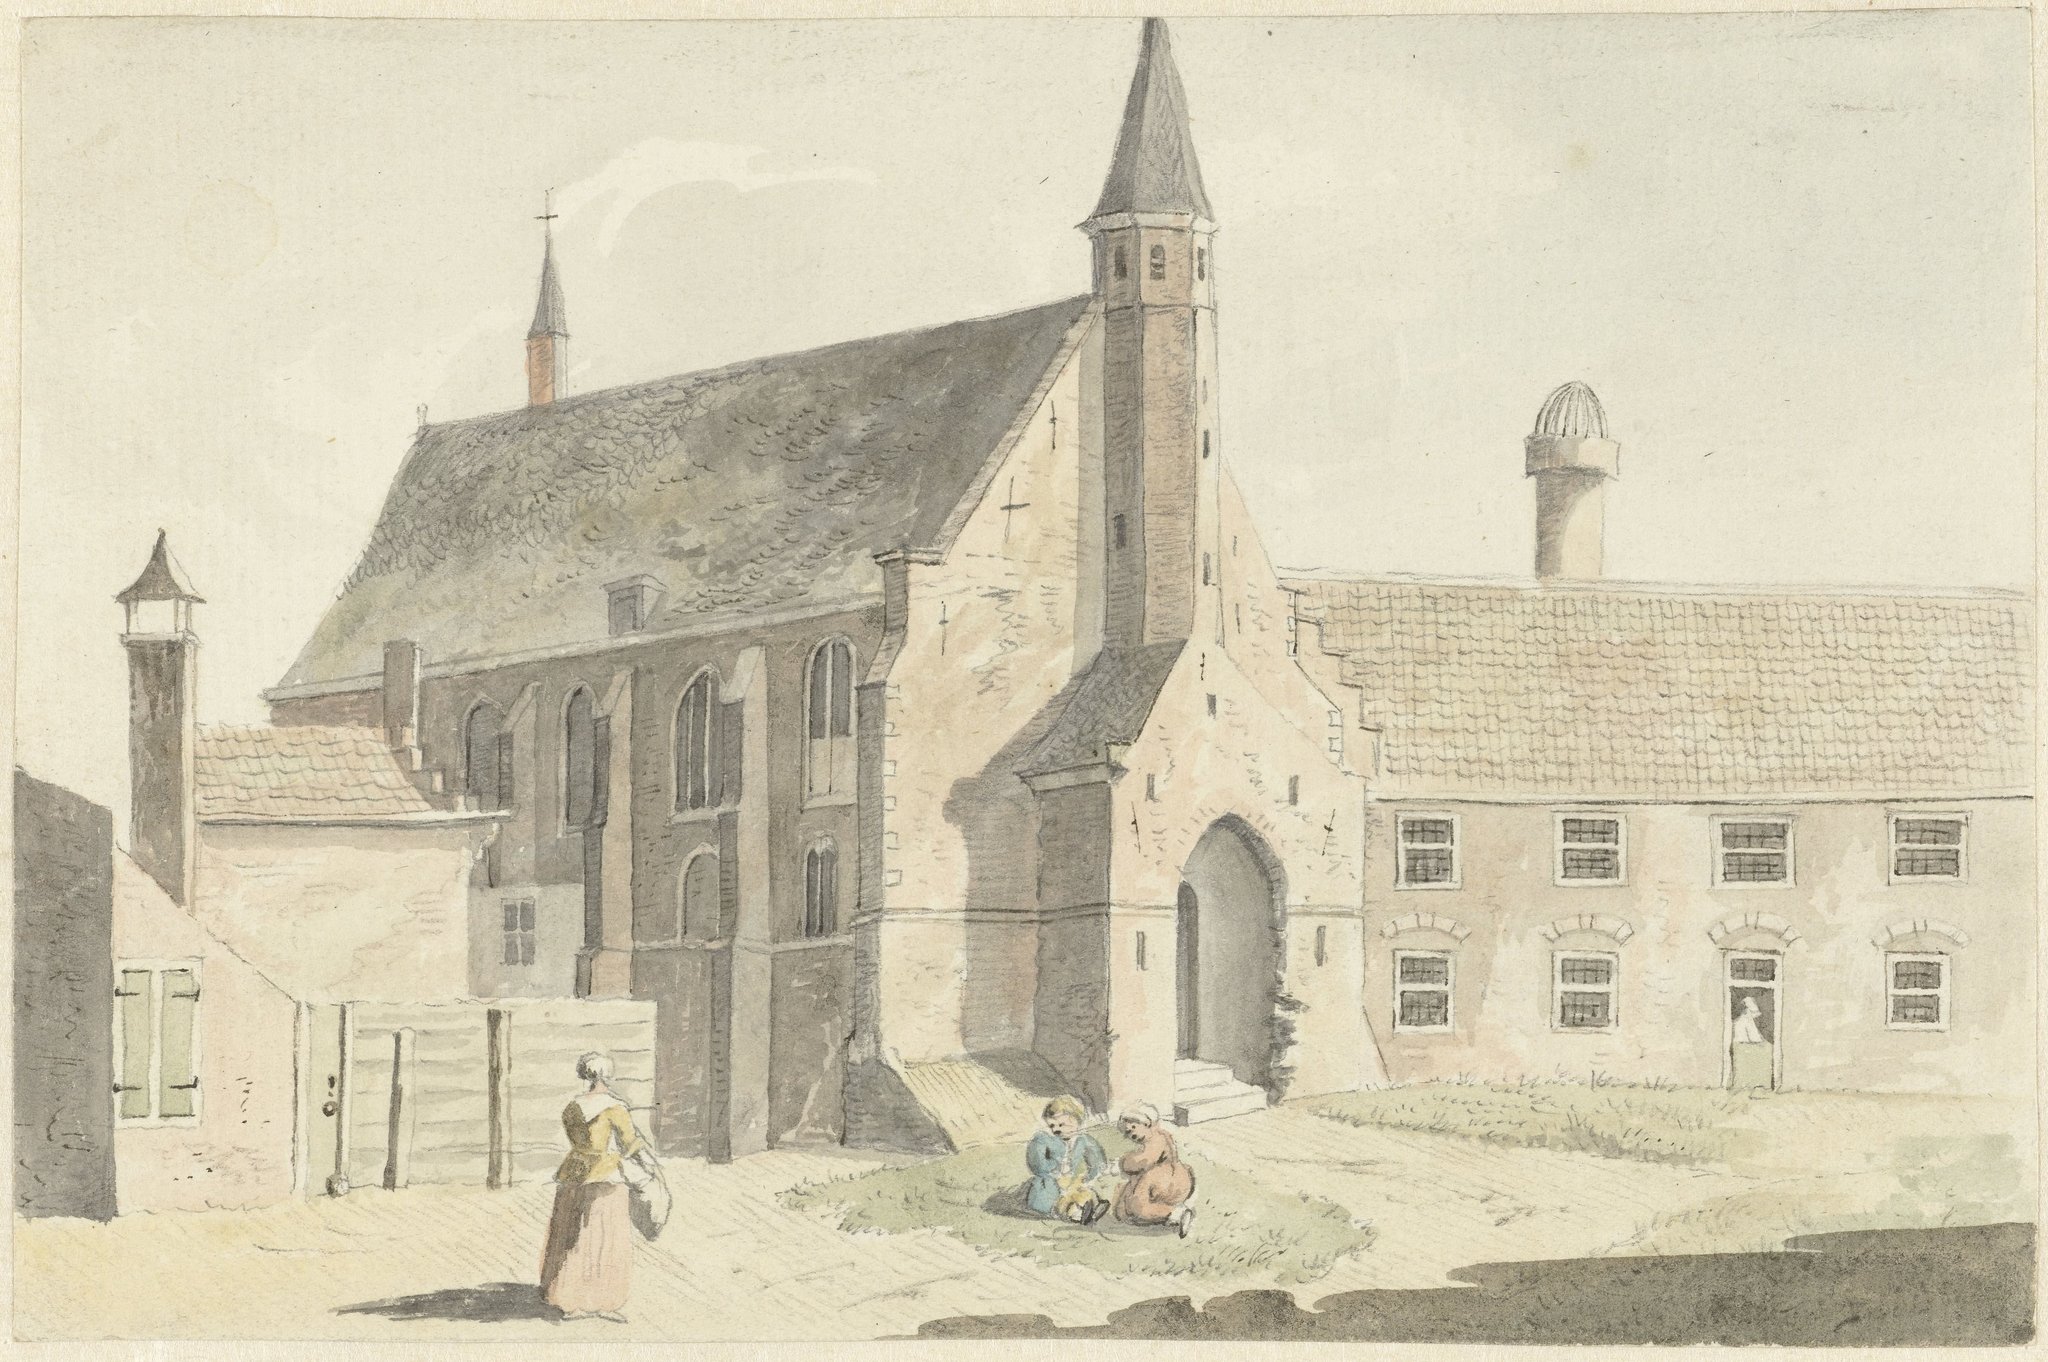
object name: drawing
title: Engelse kerk te Leiden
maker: hendrik tavenier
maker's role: draughtsman, print maker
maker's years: 1734-1807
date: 1789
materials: ink, paper, watercolor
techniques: brush, pen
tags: city-view, and landscape with man-made constructions, leiden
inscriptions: inscription: ‘Engelse kerk anatomi en Boekzaal te Lijden 1789/ H: Tavenier’